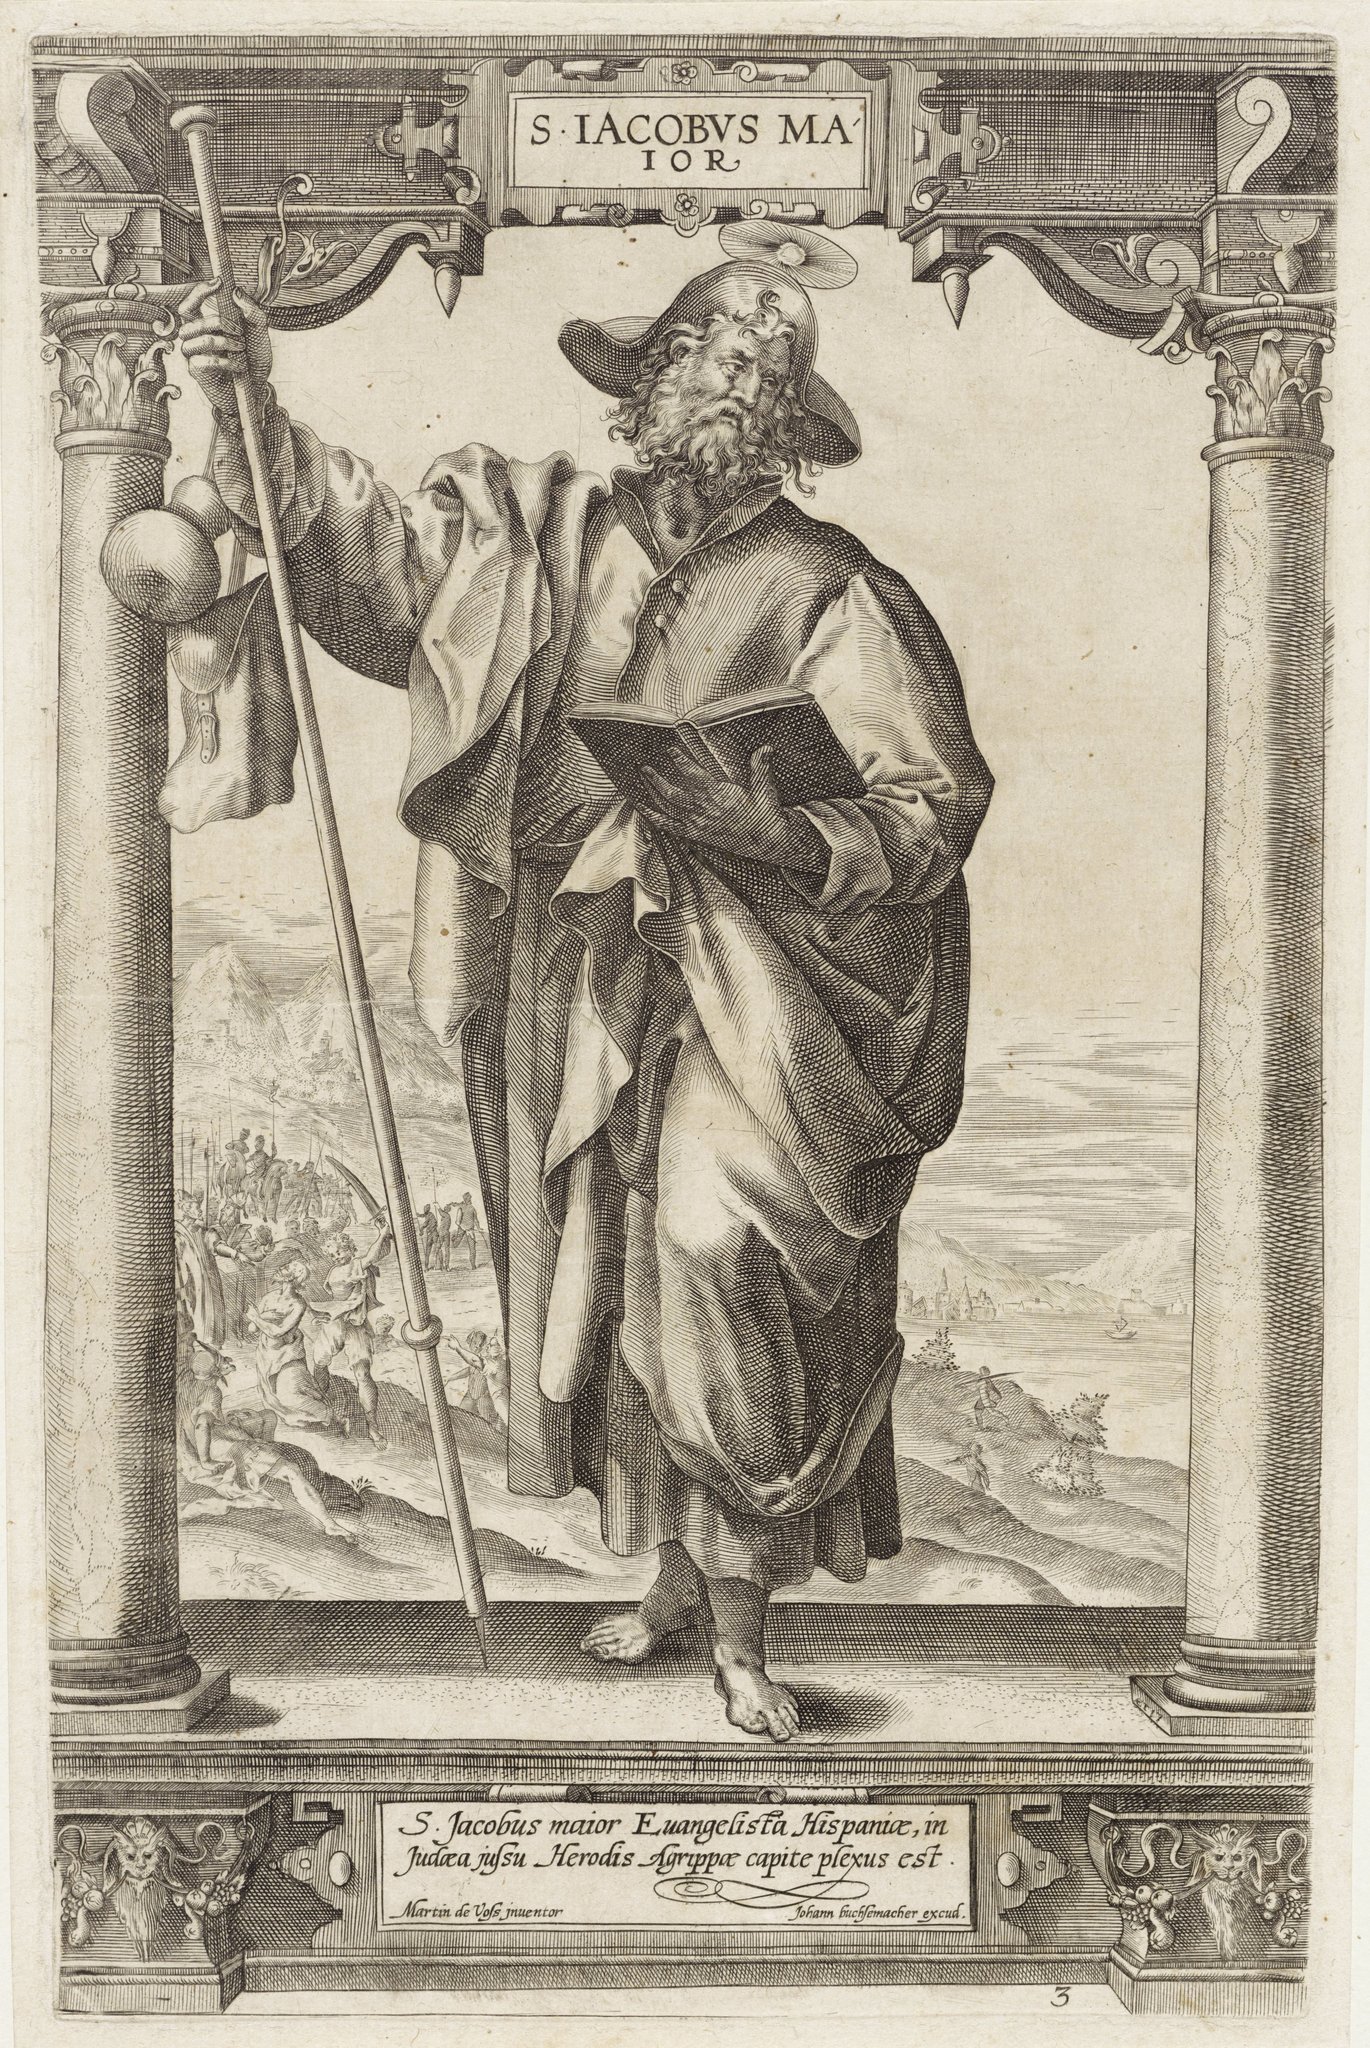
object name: print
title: Christus en de twaalf apostelen, en H. Paulus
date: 1580-1613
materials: paper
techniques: engraving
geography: antwerp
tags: column, pillar ~ architecture, beheading of james, the apostle james the great; possible attributes: book, pilgrim's cloak, hat, shell, staff, and wallet, scroll, sword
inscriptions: collector's mark: Lugt 240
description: De heilige Jakobus de Meerdere staat tussen twee zuilen in een architecturale omlijsting. In zijn ene hand houdt hij een opengeslagen boek, in de andere zijn pelgrimsstaf. Op de achtergrond wordt hij door soldaten onthoofd. In het kader onderaan een tweeregelig onderschrift in het Latijn.